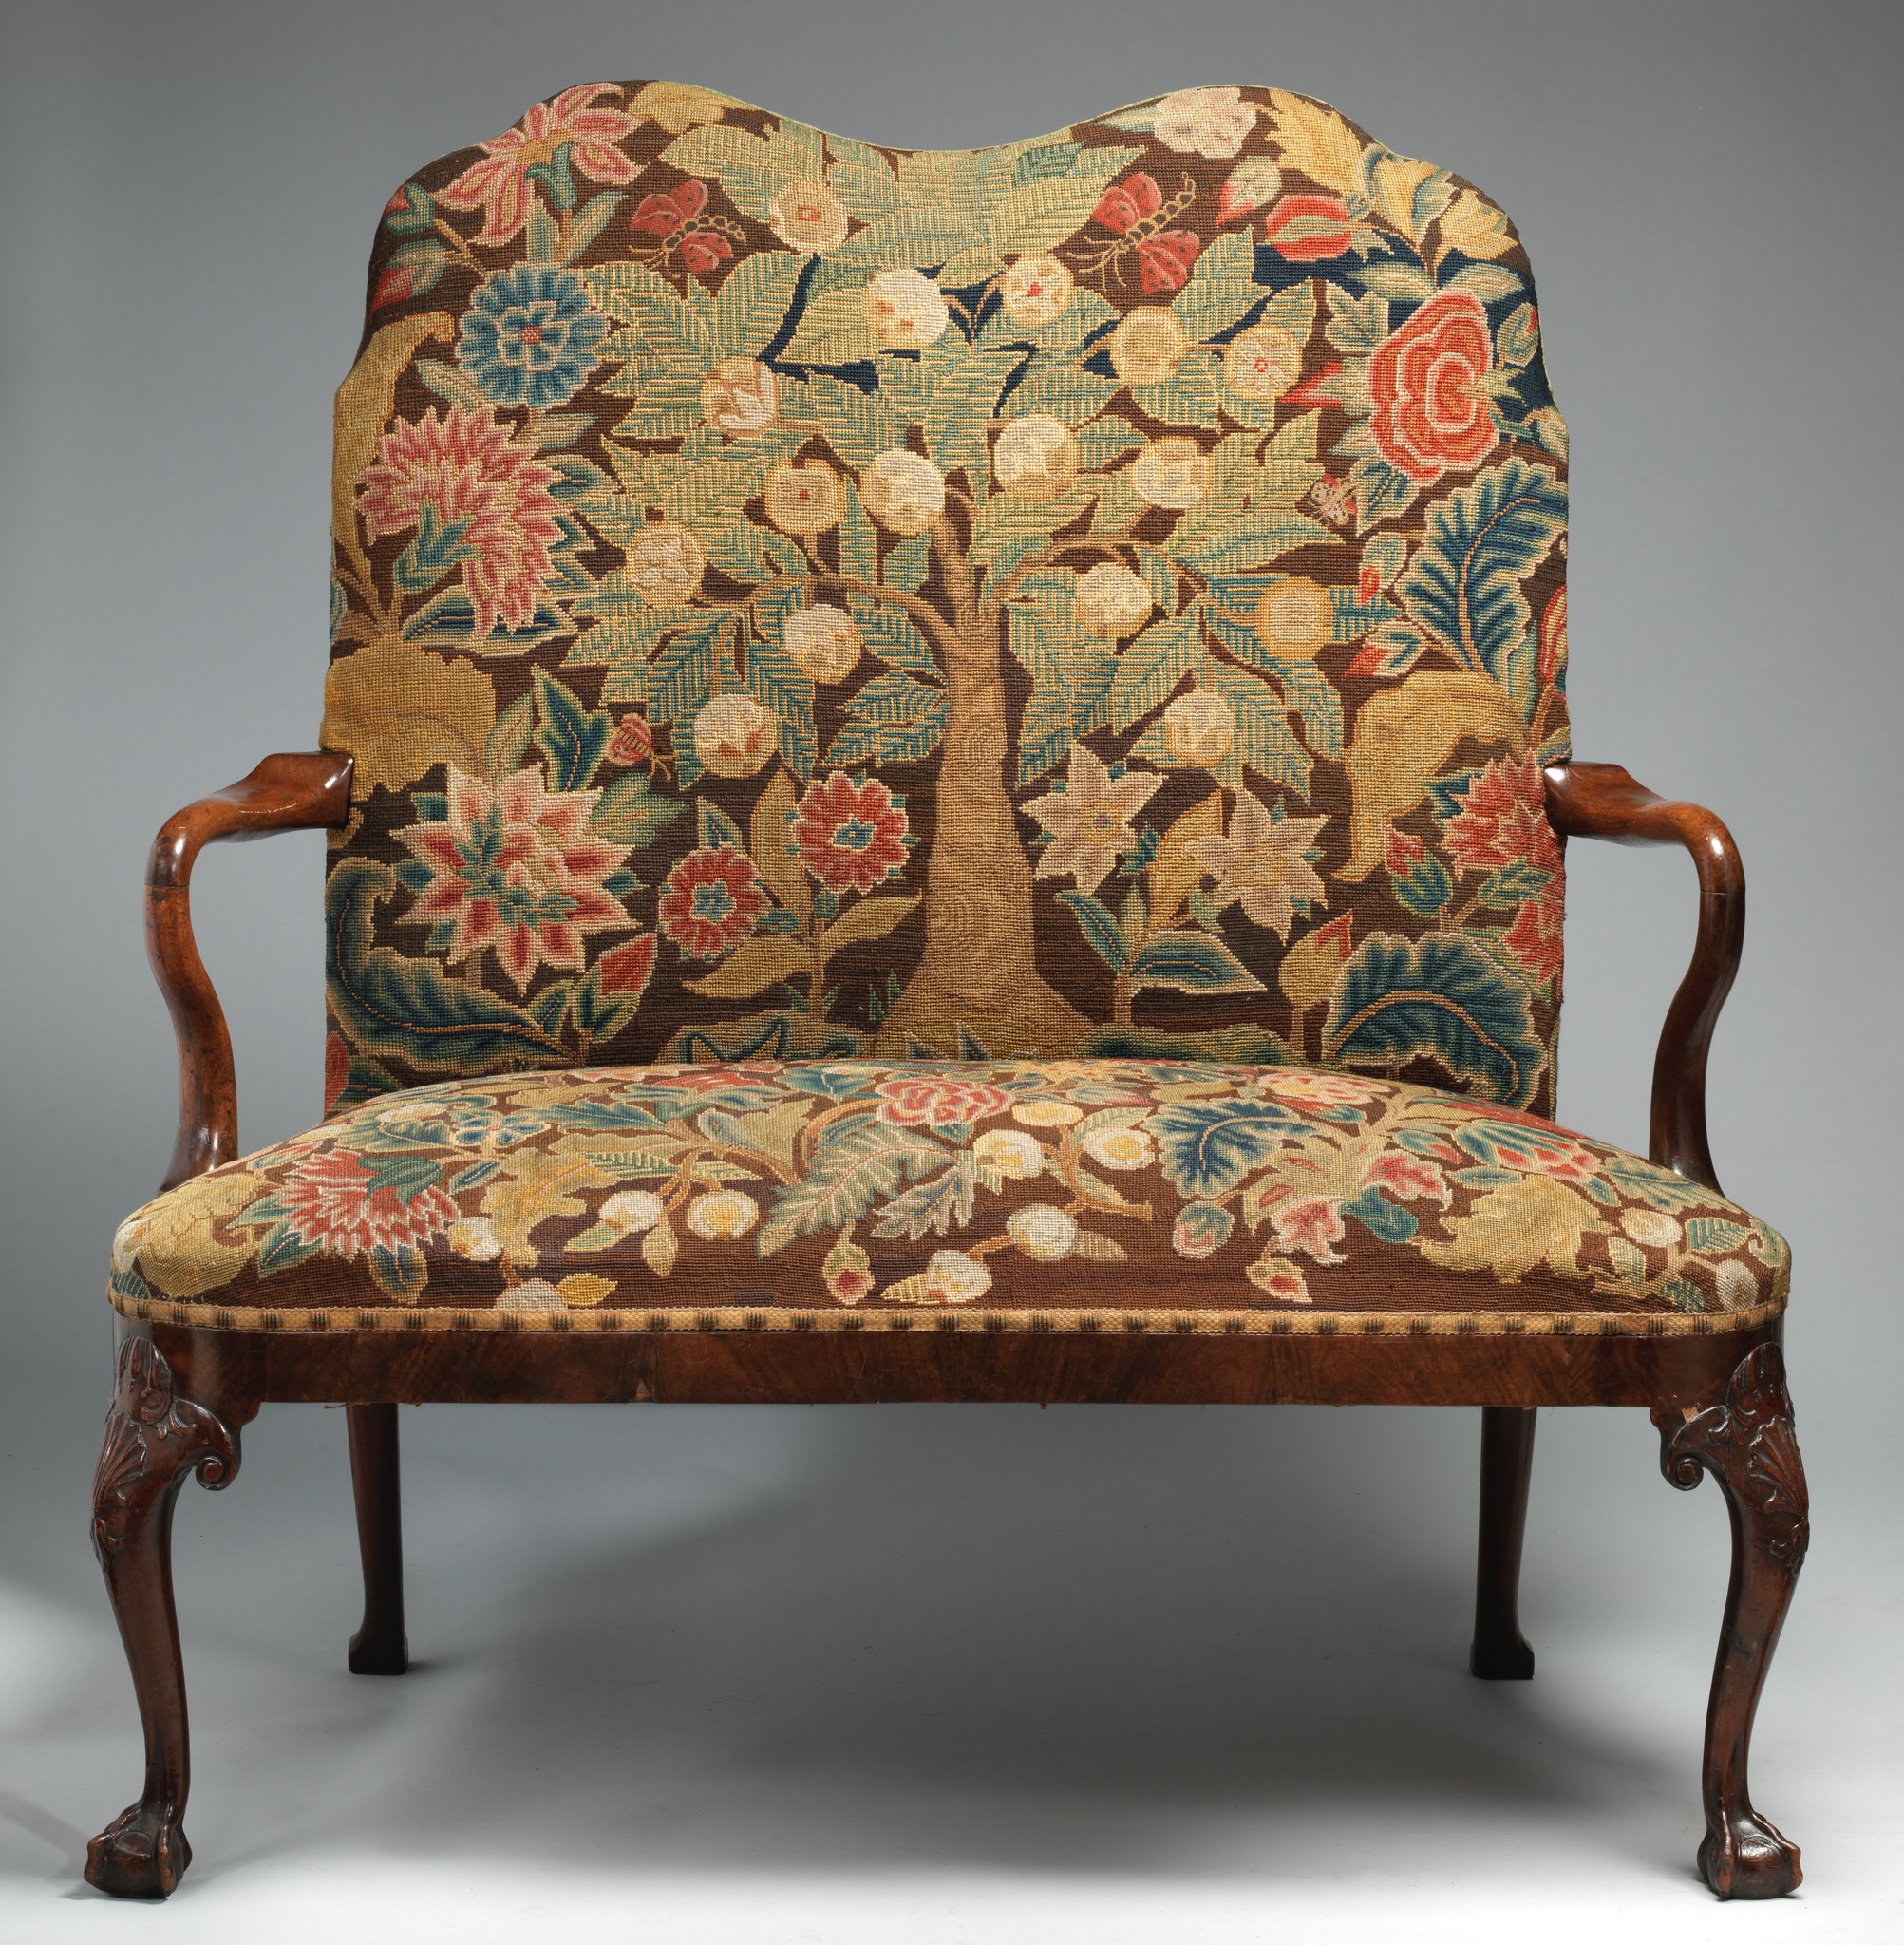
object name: settee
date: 1710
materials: canvas, wood, wool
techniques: stitching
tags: flowers,trees